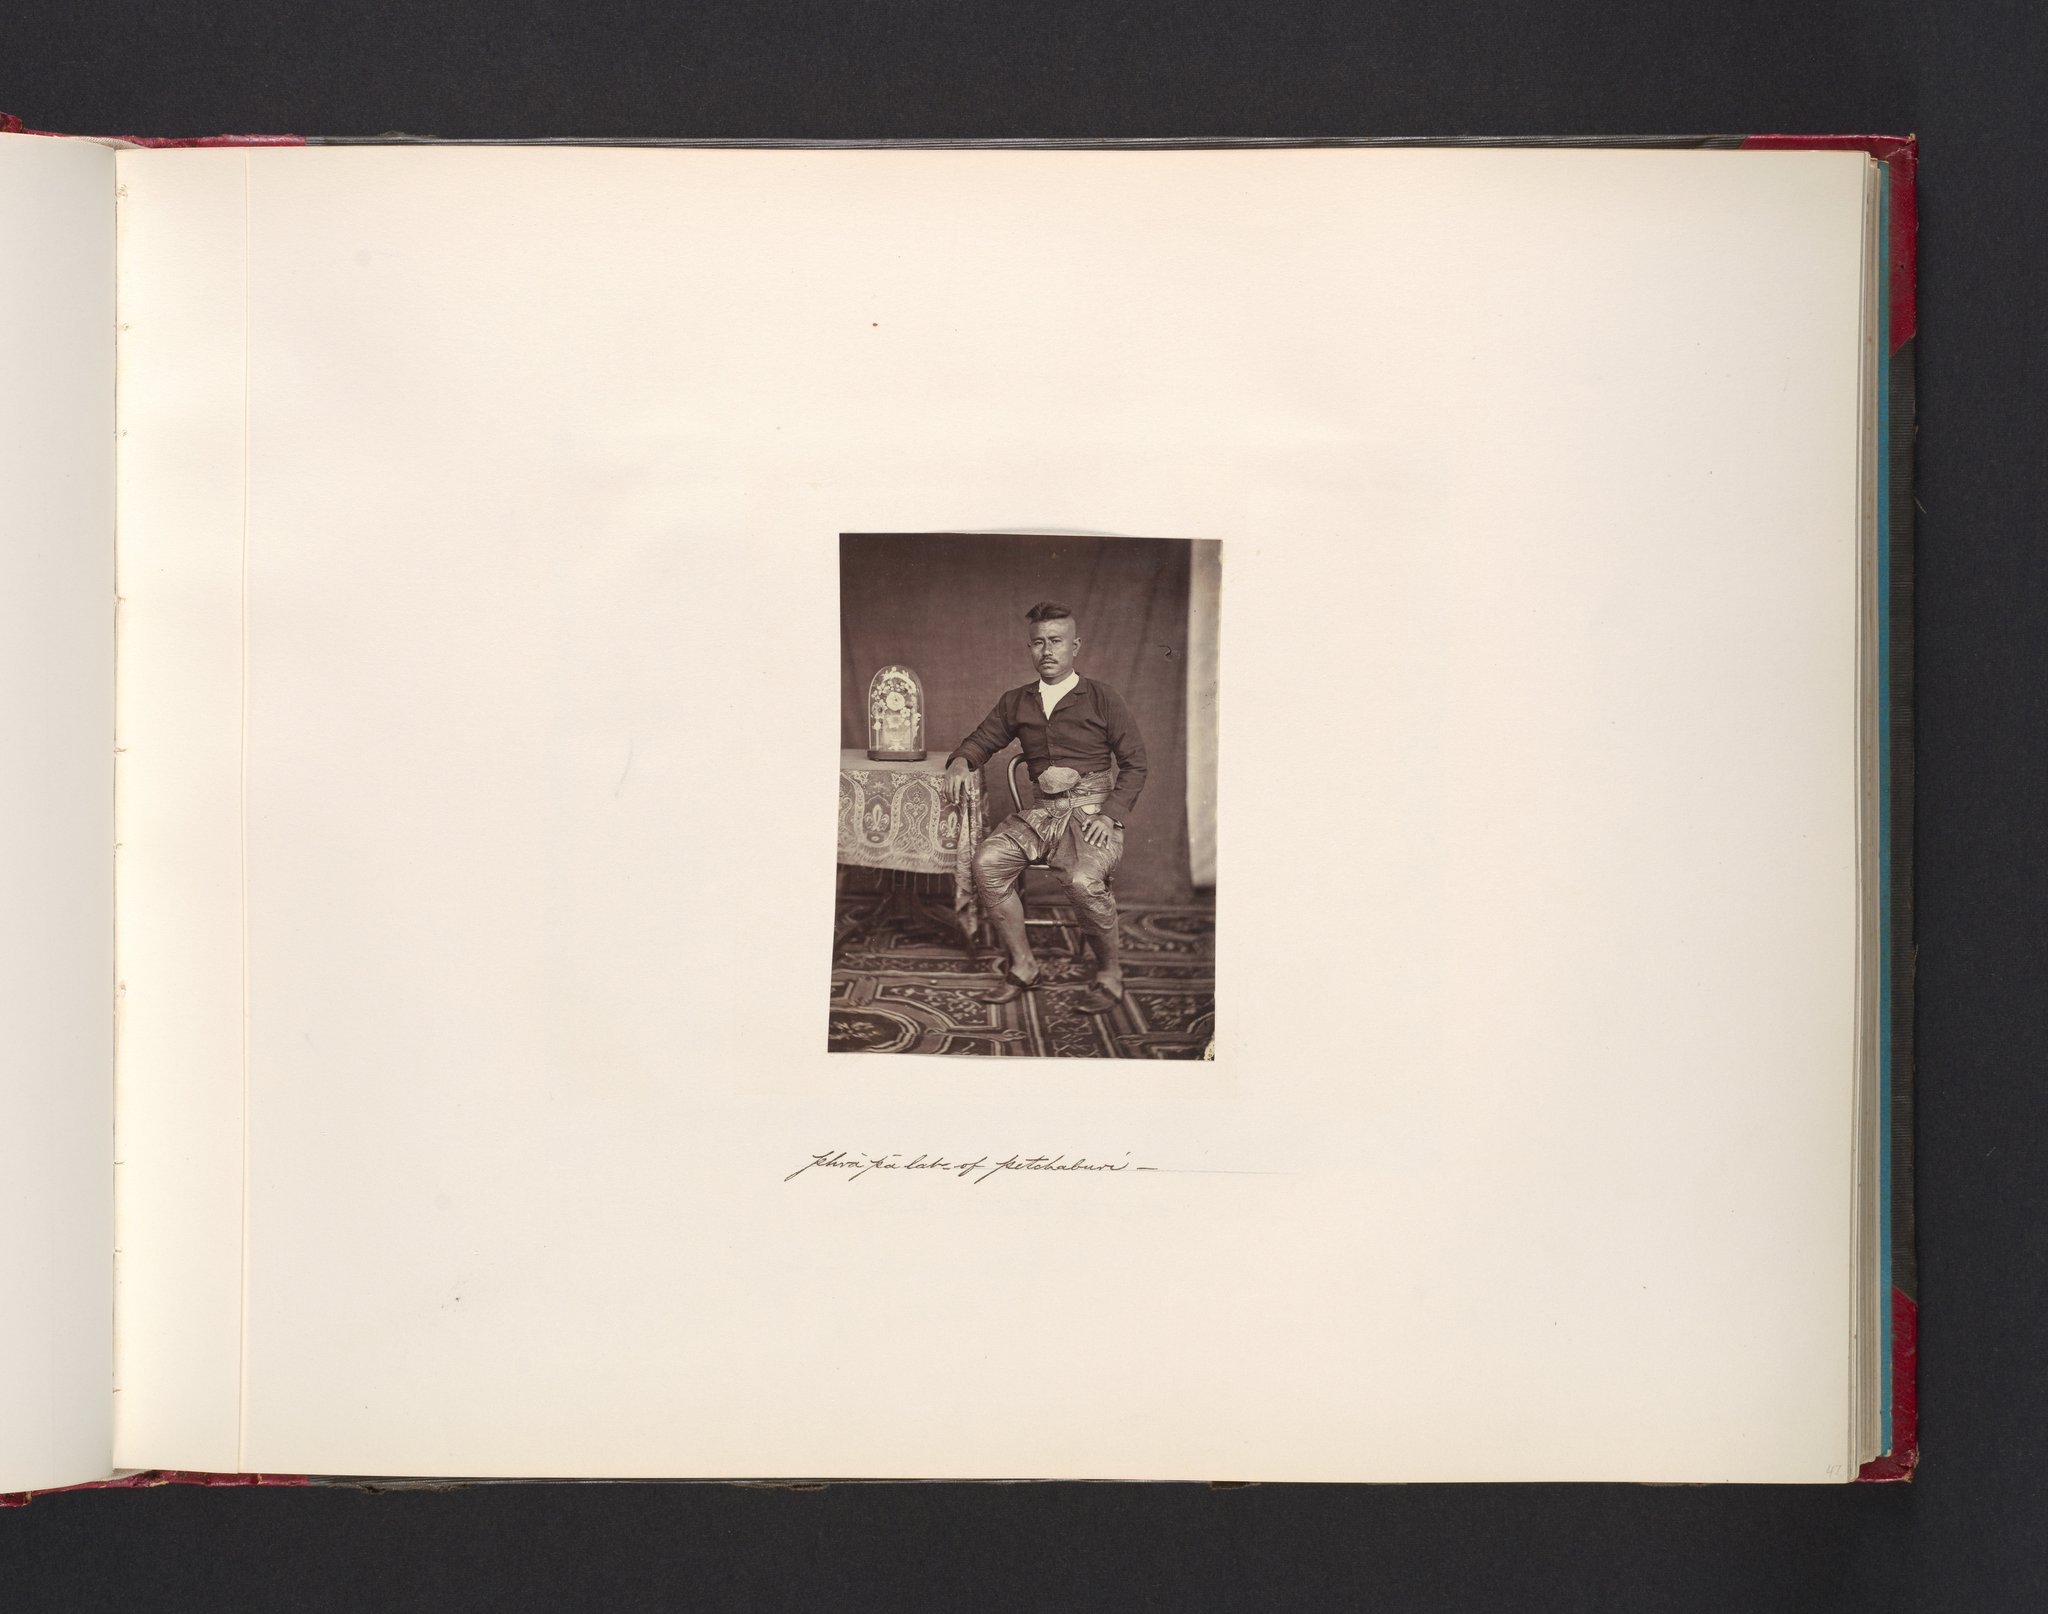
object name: photograph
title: Phra Pa Lat of Petchaburi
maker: john thomson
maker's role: artist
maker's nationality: british, scottish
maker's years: 1837-1921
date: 1865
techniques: albumen silver print, glass negative